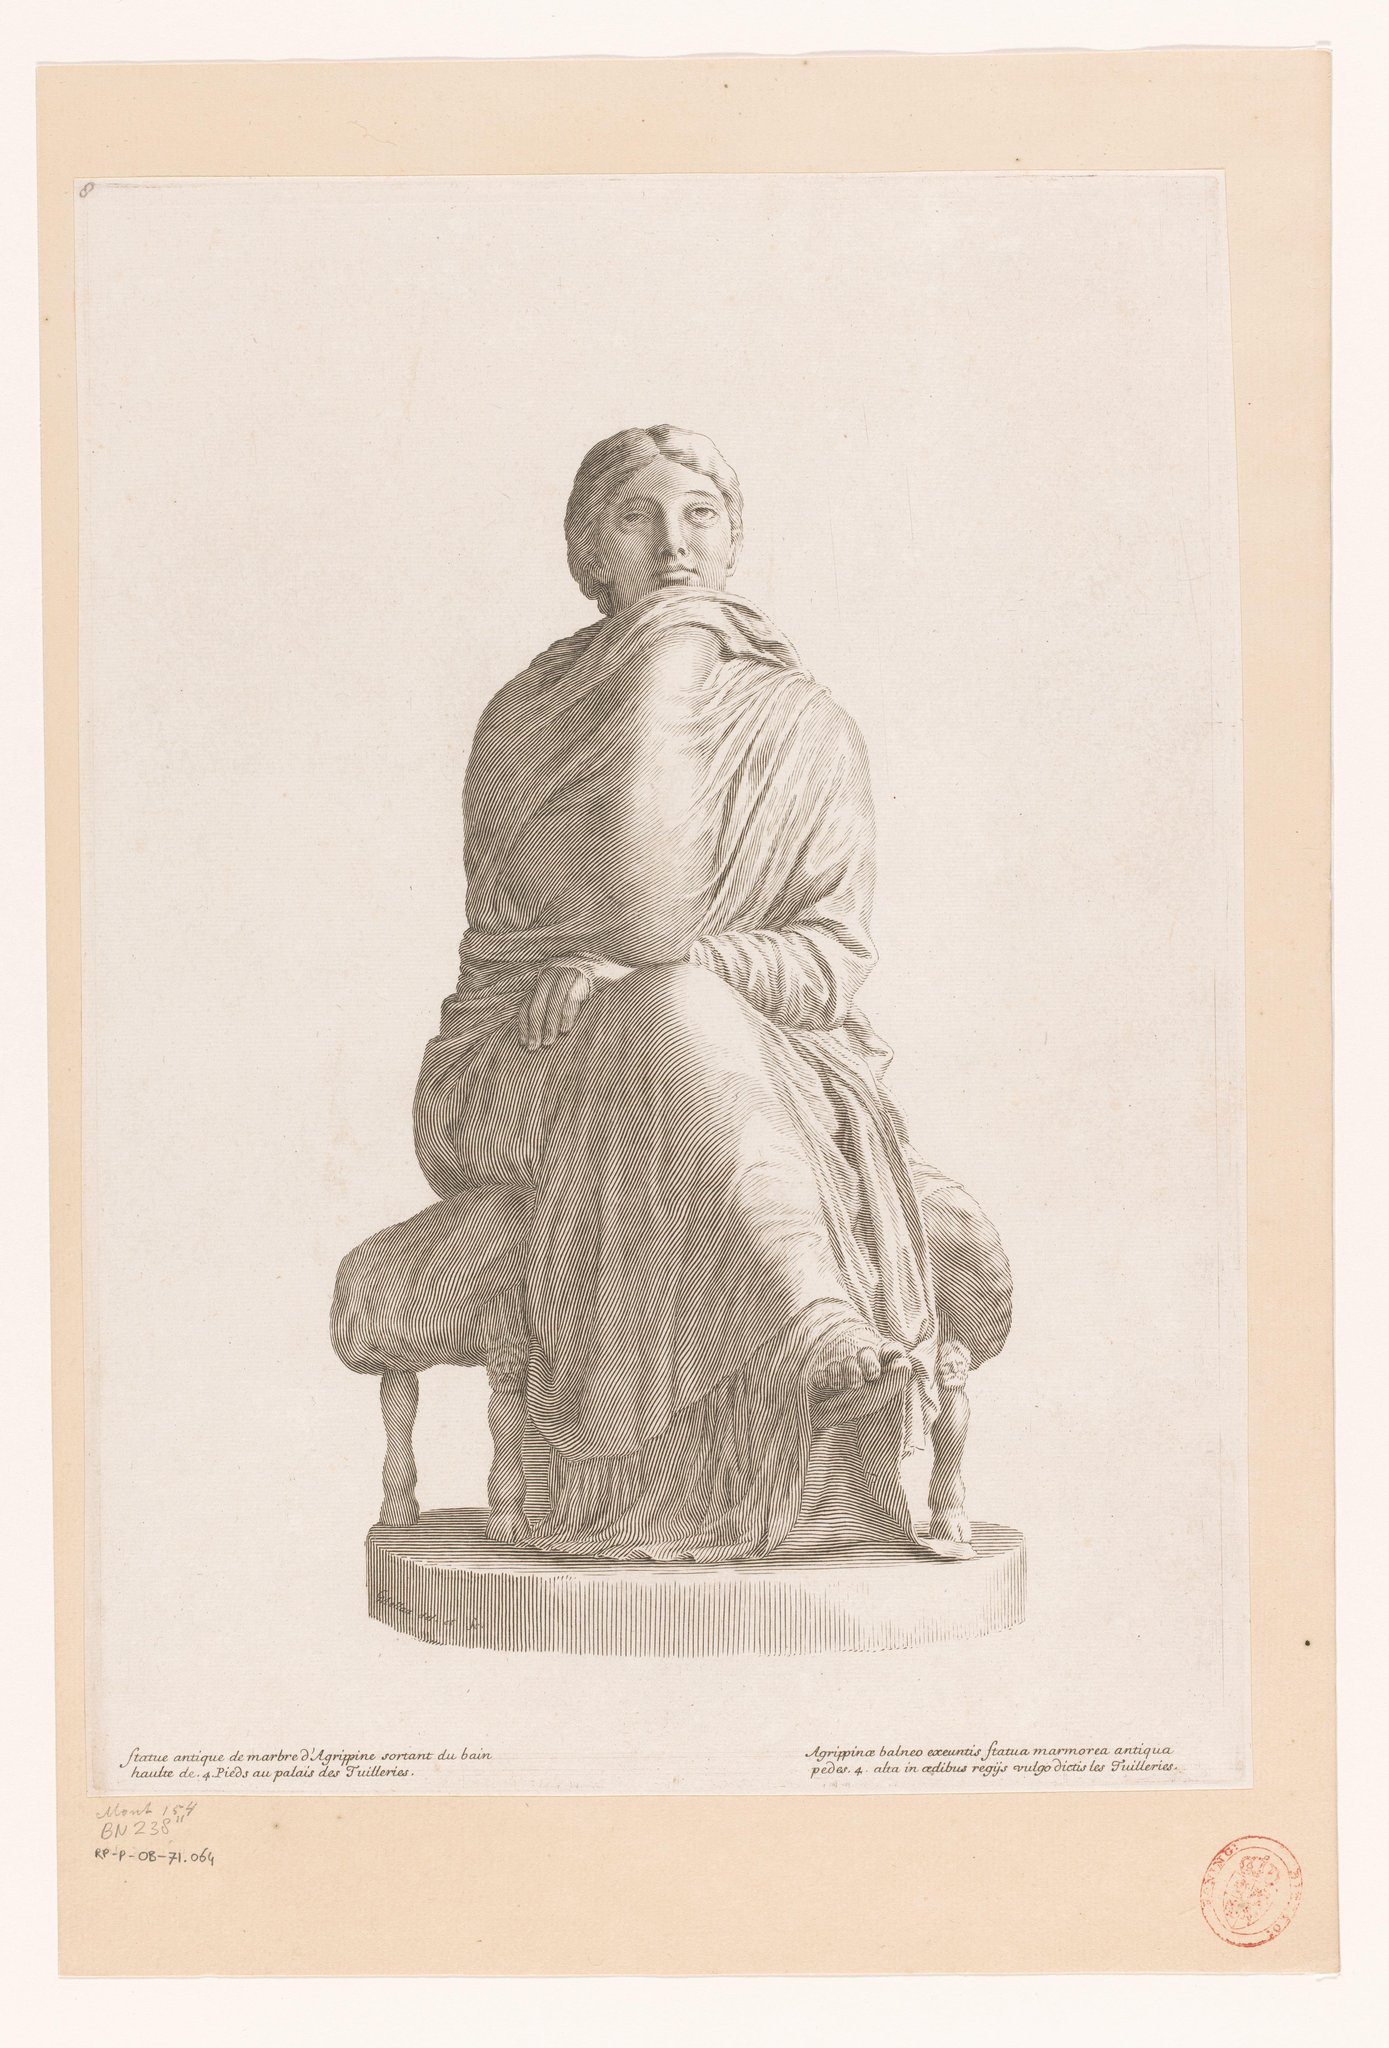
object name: print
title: Standbeeld van een zittende vrouw in draperie gewikkeld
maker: claude mellan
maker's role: draughtsman, print maker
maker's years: 1598-1688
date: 1608-1677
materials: paper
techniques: engraving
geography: paris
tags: sitting figure - aa - female human figure, piece of sculpture, reproduction of a piece of sculpture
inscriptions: collector's mark: Lugt 240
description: Prent gebruikt voor: Félibien, André. Tableaux du Cabinet du roy. Statues et bustes antiques des maisons royales. Parijs: Imprimerie Royale, 1677. Het boek bevat 61 prenten van beelden en bustes uit Franse koninklijke collectie. Mellan vervaardigde in totaal achttien platen (zie ook British Museum, inv.nr. 1874,0808.1488). Het beeld, ook bekend als 'Mnémosyne', bevindt zich op het terras van het palais Compiègne.